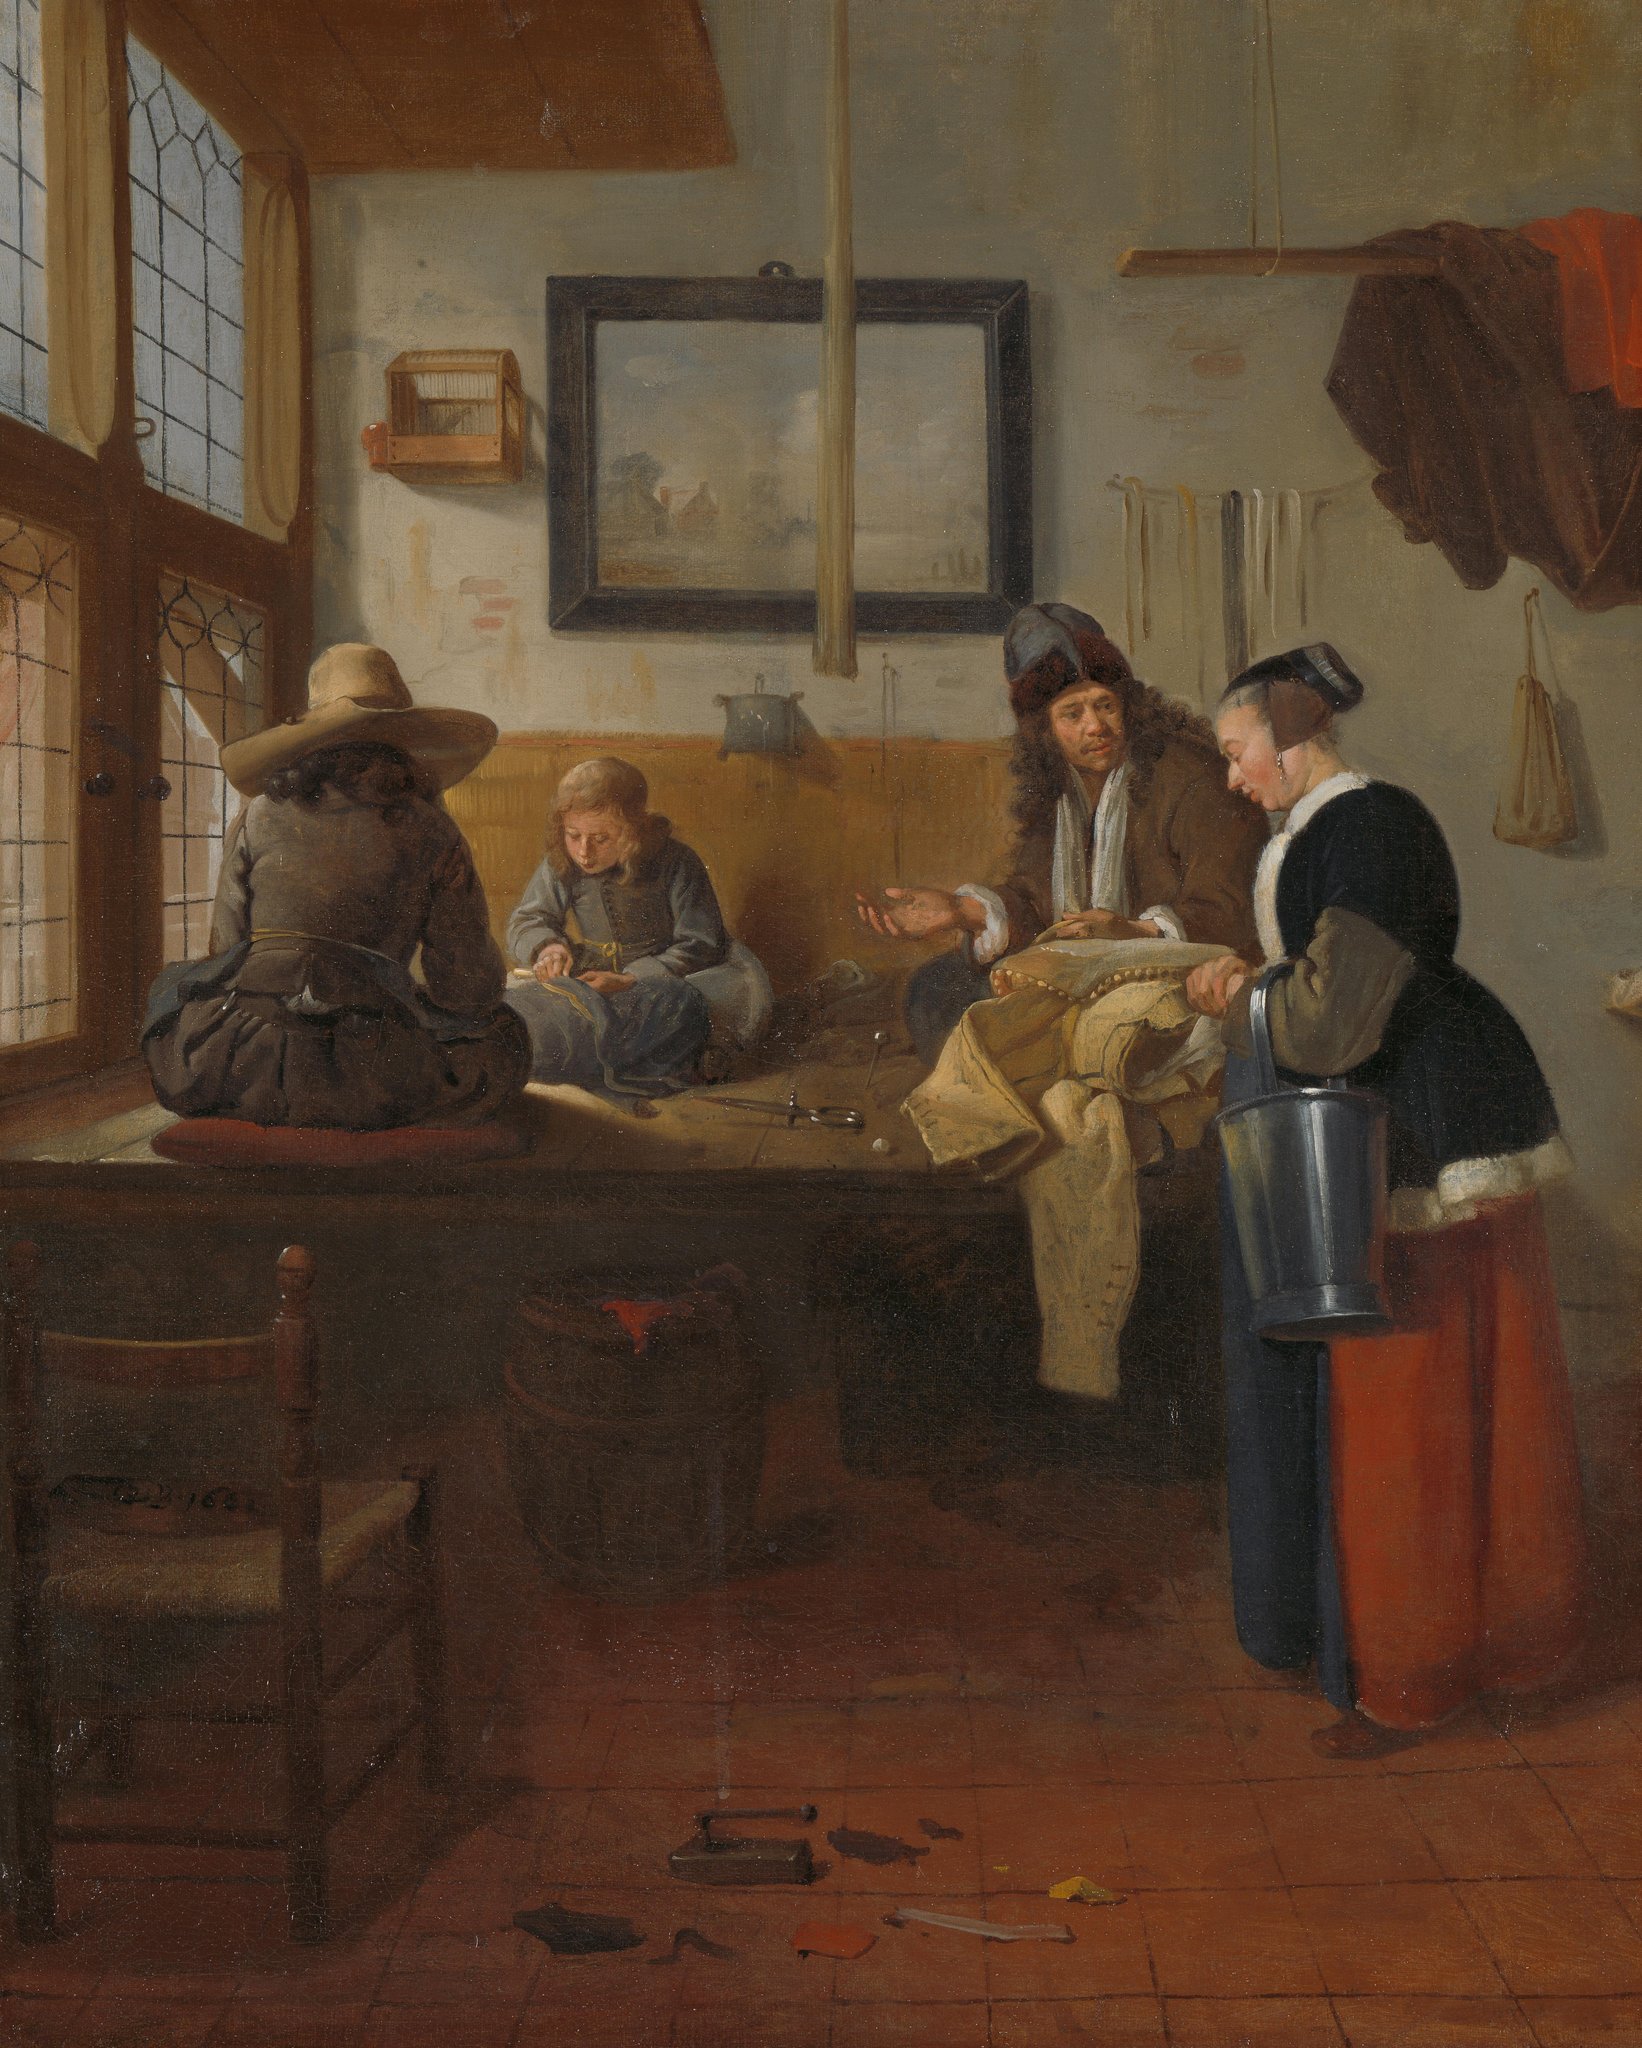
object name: painting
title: The Tailor's Workshop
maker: quiringh gerritsz. van brekelenkam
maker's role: draughtsman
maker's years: 1622-1669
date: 1661-1662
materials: canvas, oil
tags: tools, aids, implements ~ crafts and industries: scissors, workshop-interior, tailor, dressmaker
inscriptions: signature and date: ‘Q.B. 1661’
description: A woman runs errands with a market bucket on her arm. Inside the tailor’s workshop, she deliberates over a coat. The tailors are seated on a raised platform to make the most of the daylight. A hank of thread hangs at the ready above the table. Hanging on the wall is a river landscape, dispelling the notion that only affluent individuals could afford to have paintings in their homes in the 17th century.